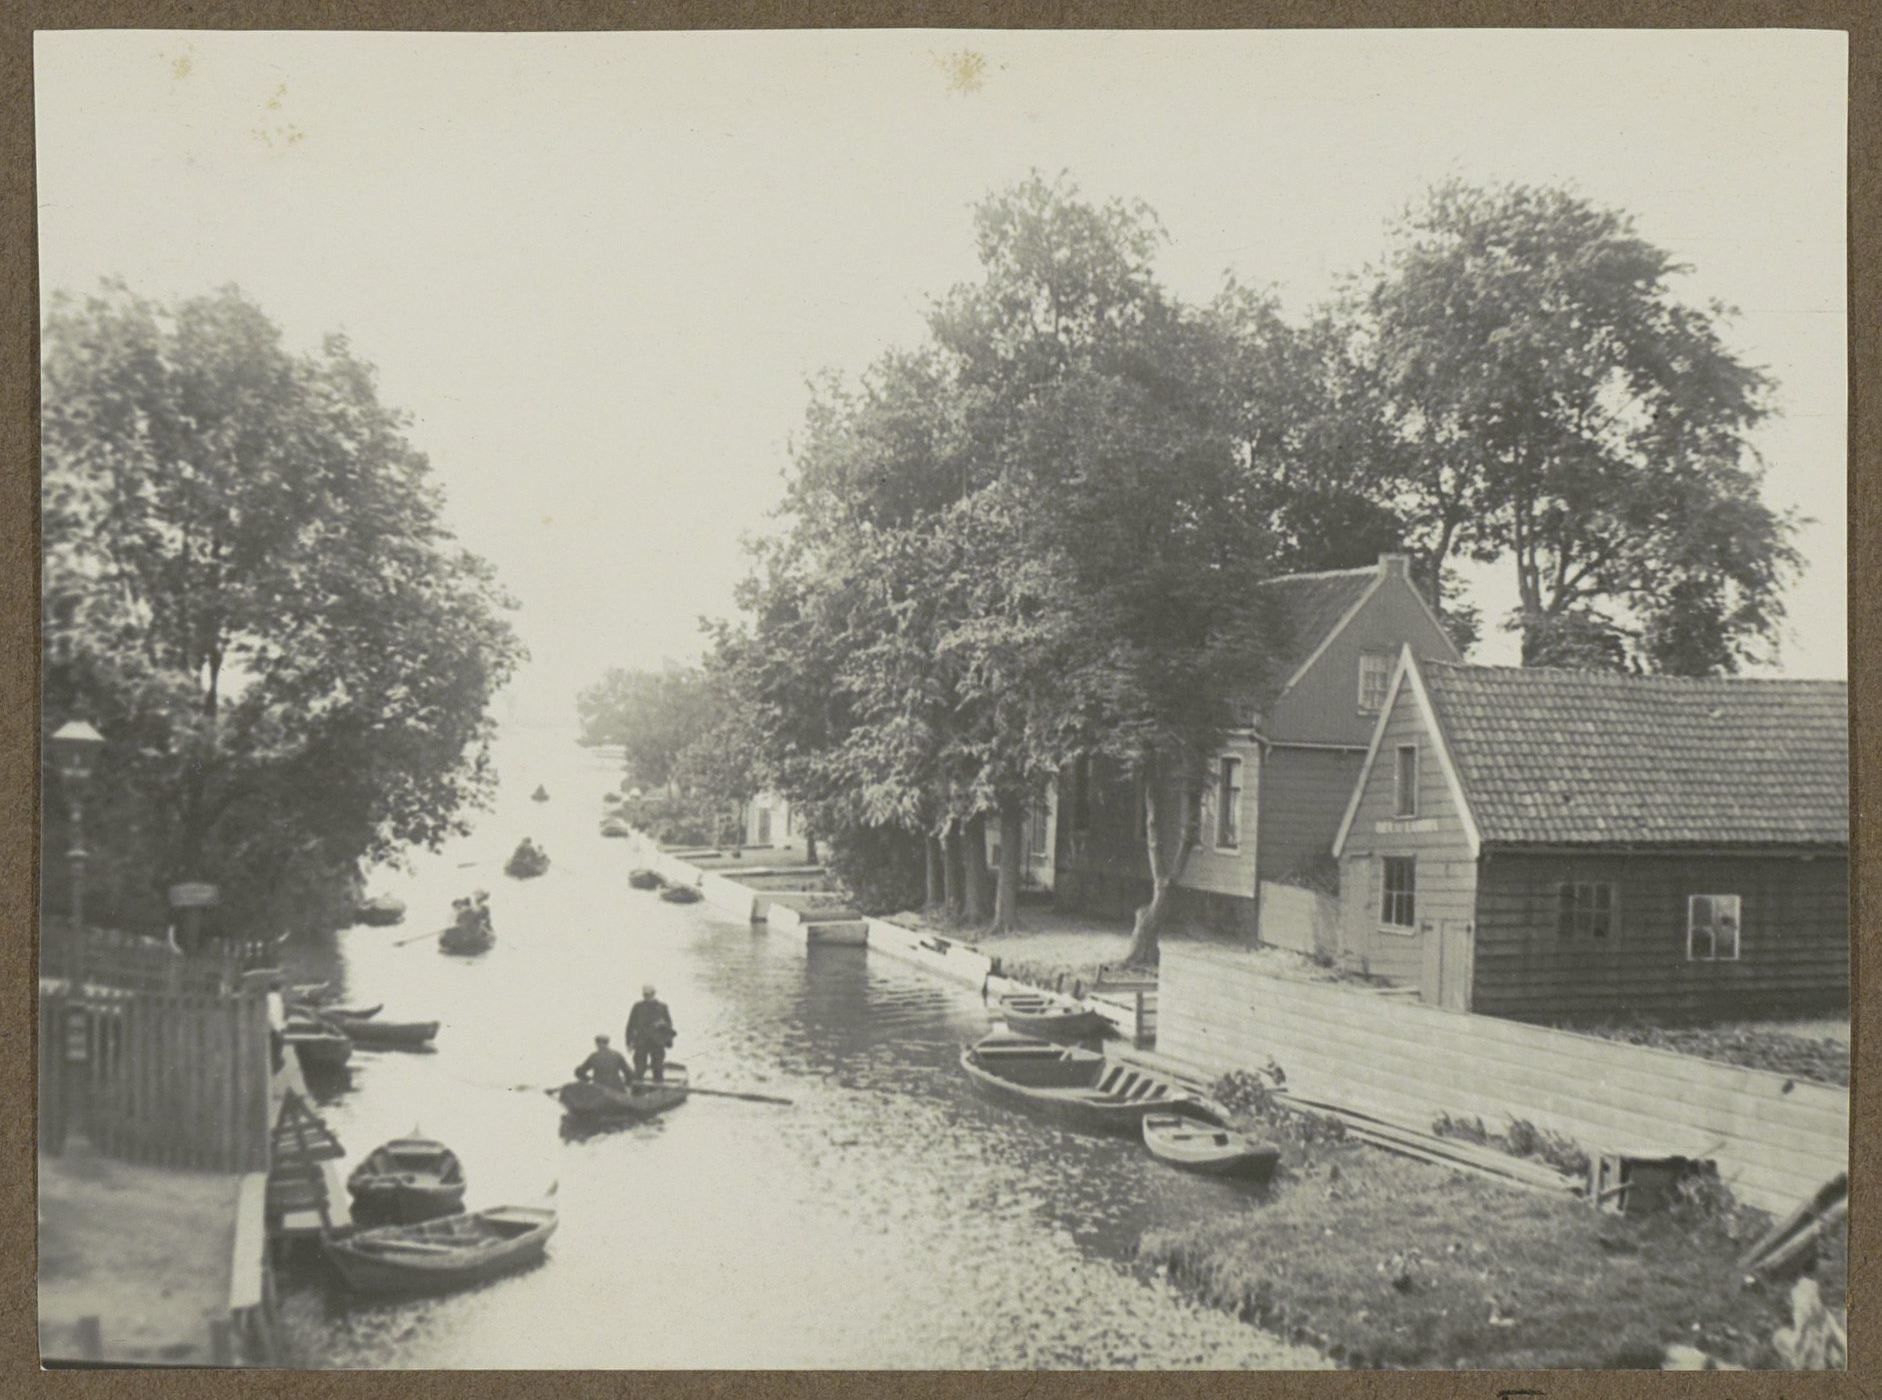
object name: photograph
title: Roeiboten bij Hofwijck, vermoedelijk in Amsterdam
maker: Anonymous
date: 1910-1930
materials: paper, photographic support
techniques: gelatin silver print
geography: amsterdam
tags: small canal, ditch, amsterdam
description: Onderdeel van Album met foto's van Amsterdam en omgeving.